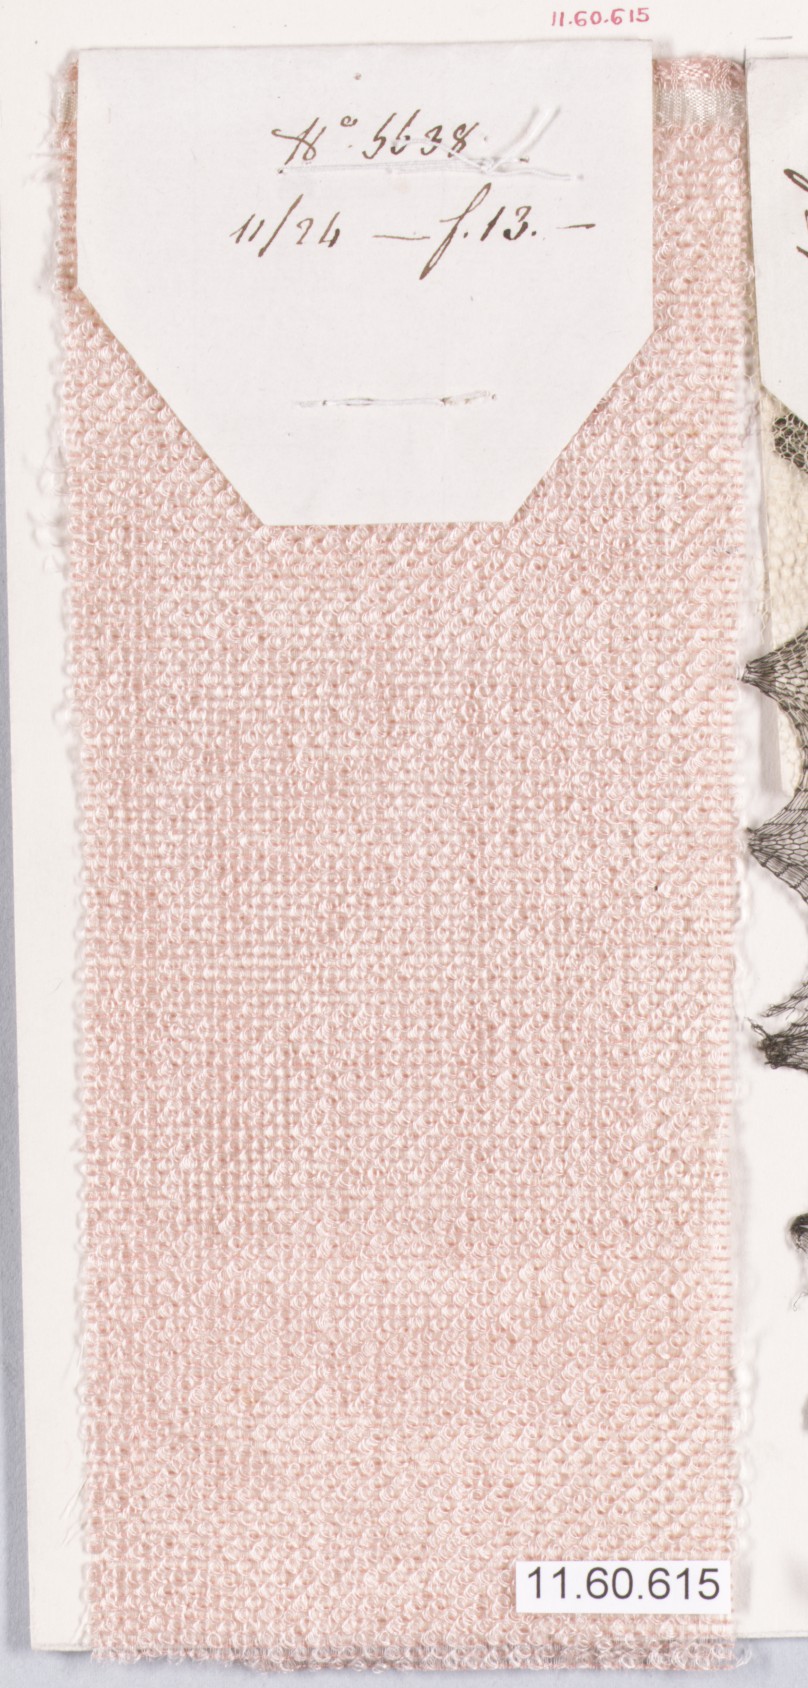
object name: sample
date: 1801-1833